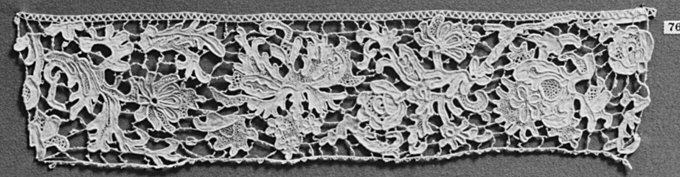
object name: piece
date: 1601-1700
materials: lace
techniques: lace, gros point